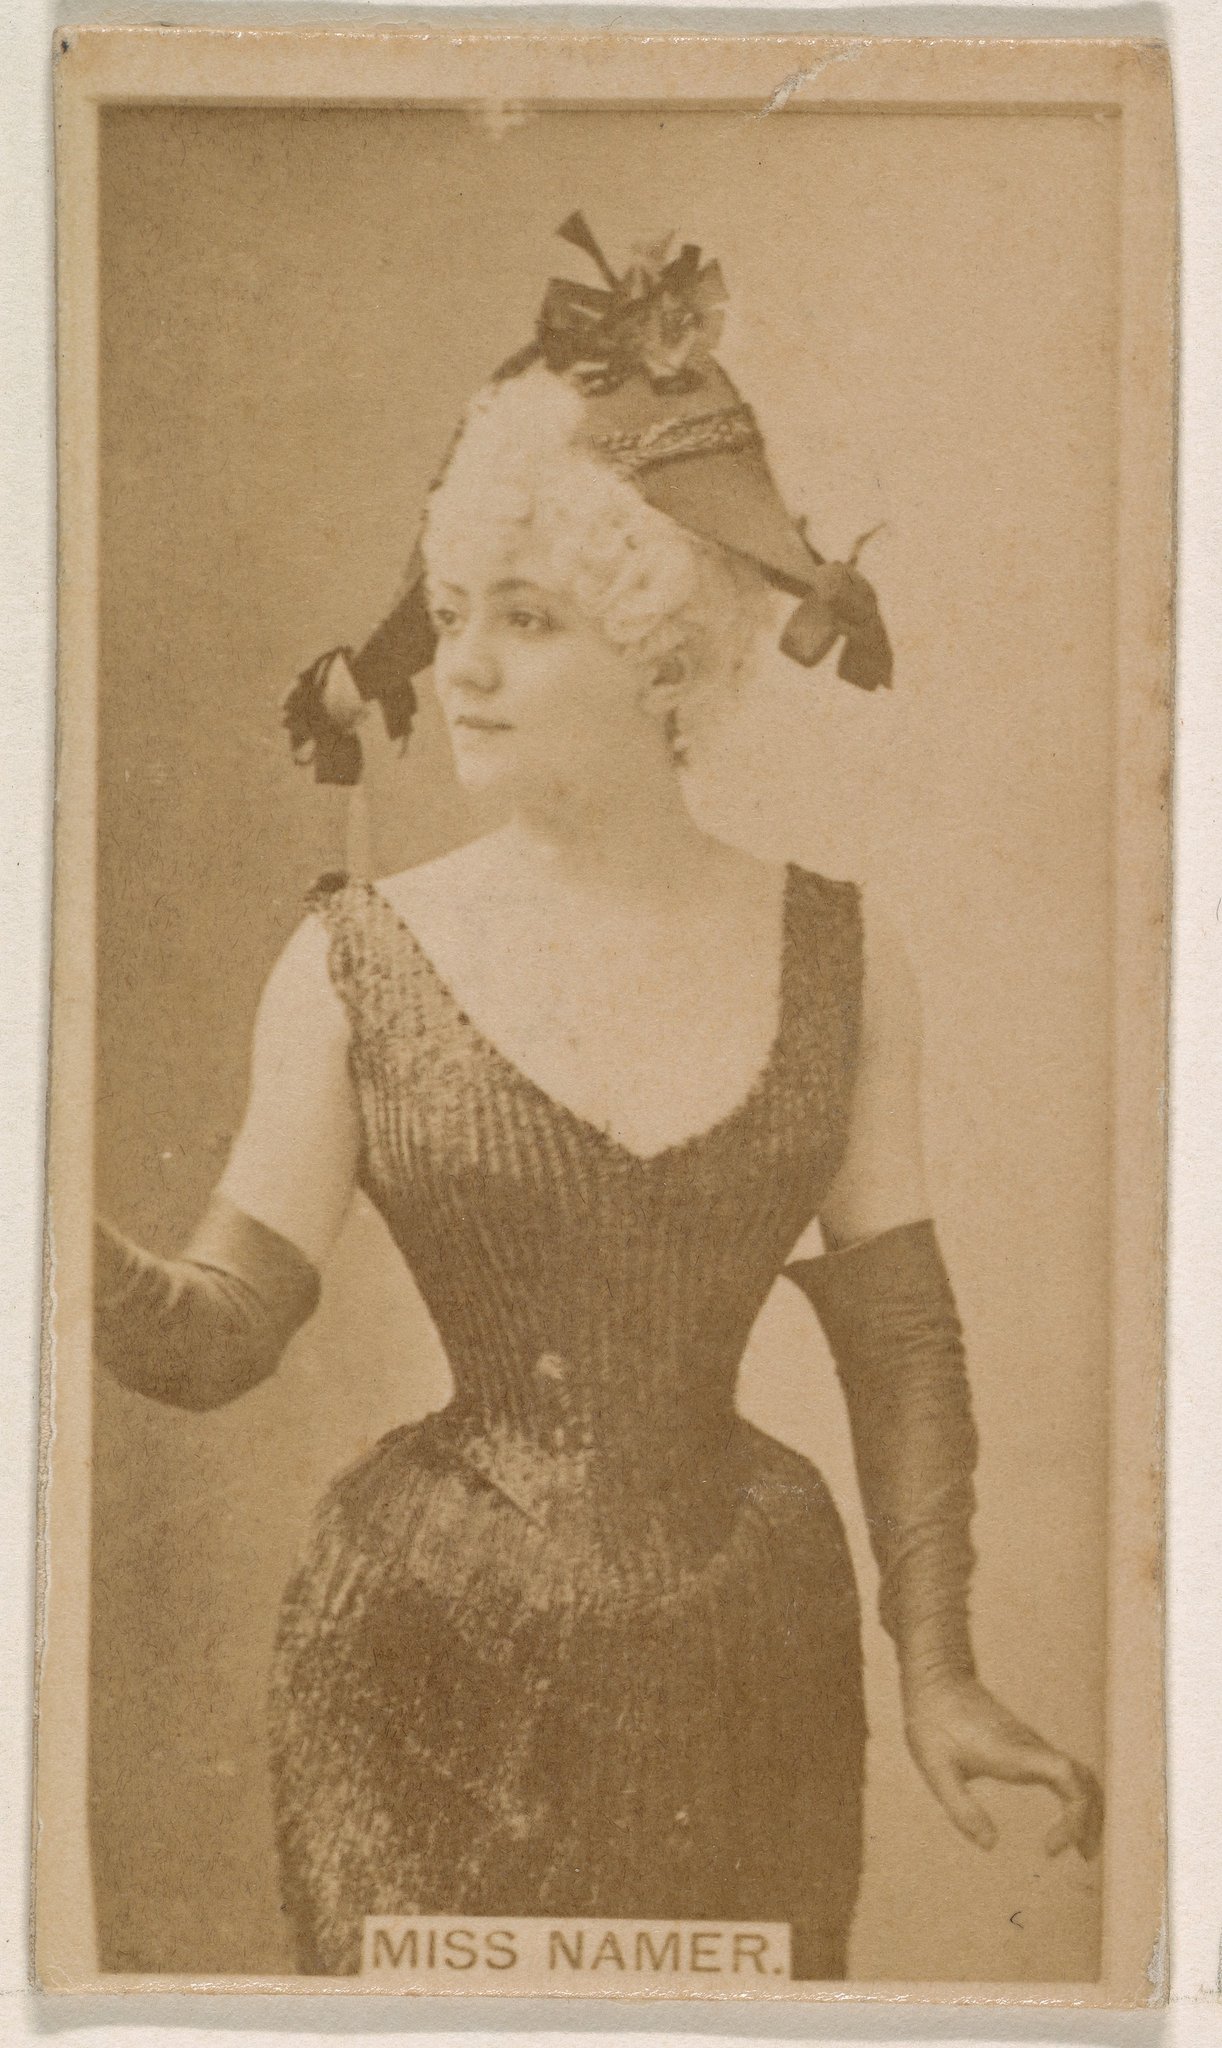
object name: photograph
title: Miss Namer, from the Actresses series (N245) issued by Kinney Brothers to promote Sweet Caporal Cigarettes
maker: kinney brothers tobacco company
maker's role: publisher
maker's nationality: american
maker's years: 1869-2011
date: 1890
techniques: albumen silver print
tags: portraits,women,actresses